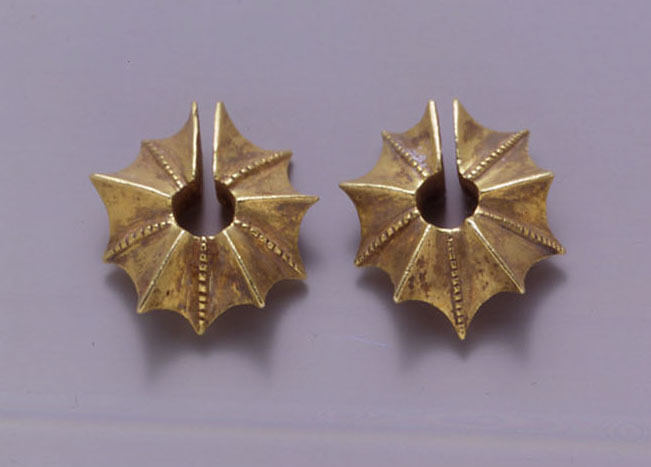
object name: ear clip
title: Pair of Ear Clips in the Shape of a Starfruit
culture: indonesian, javanese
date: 701-933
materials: gold